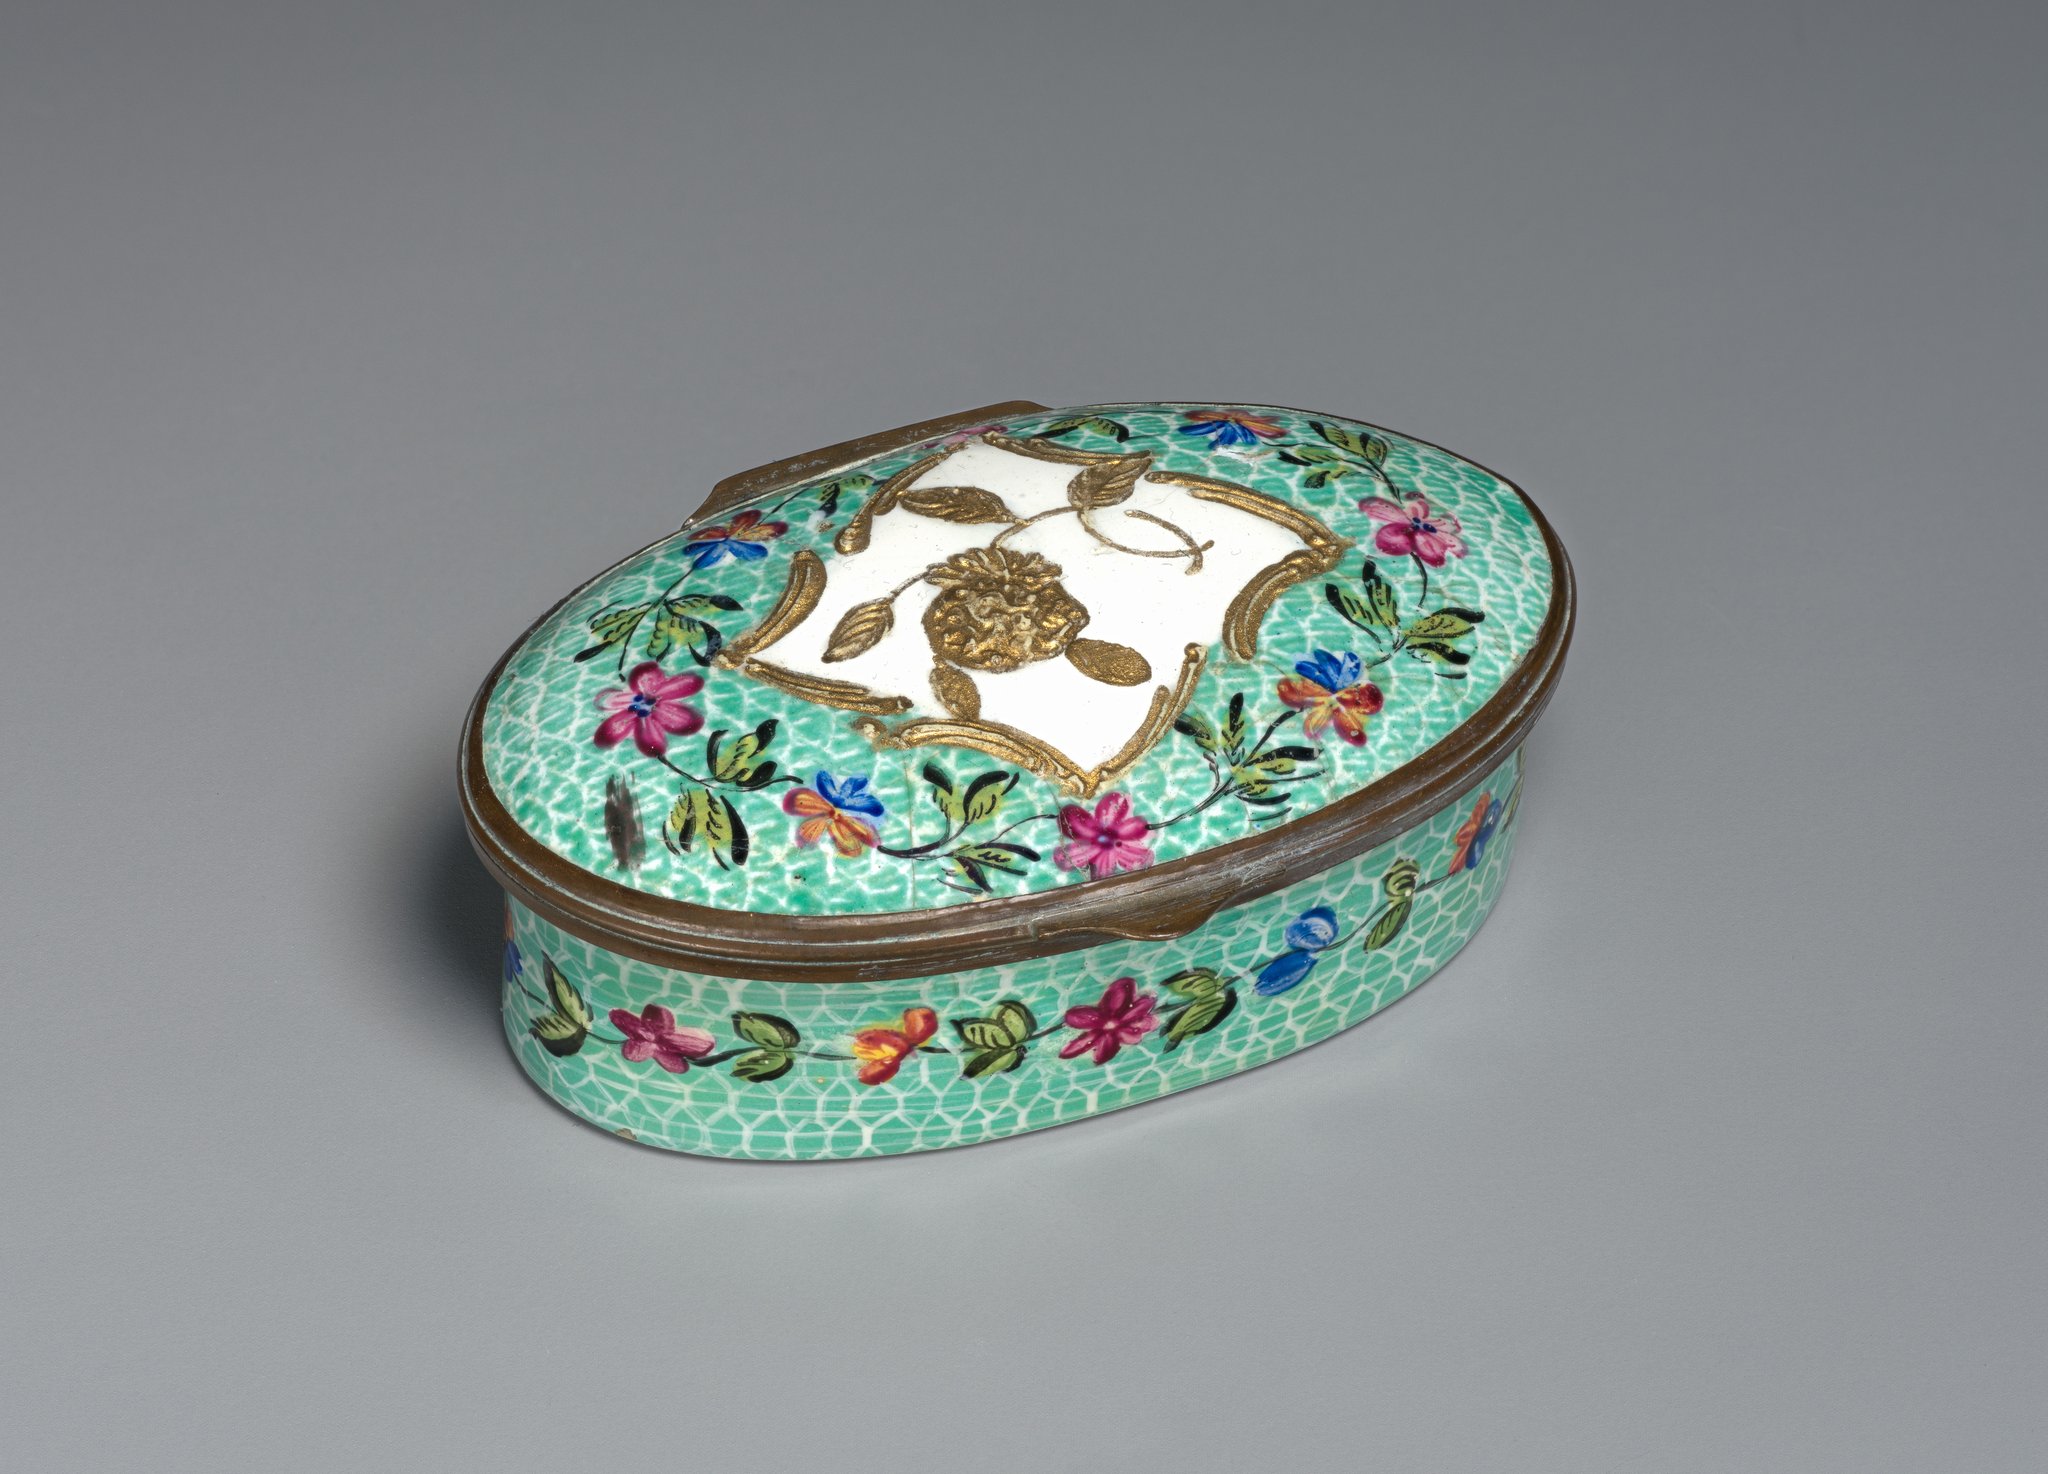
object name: snuffbox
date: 1770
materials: copper, enamel